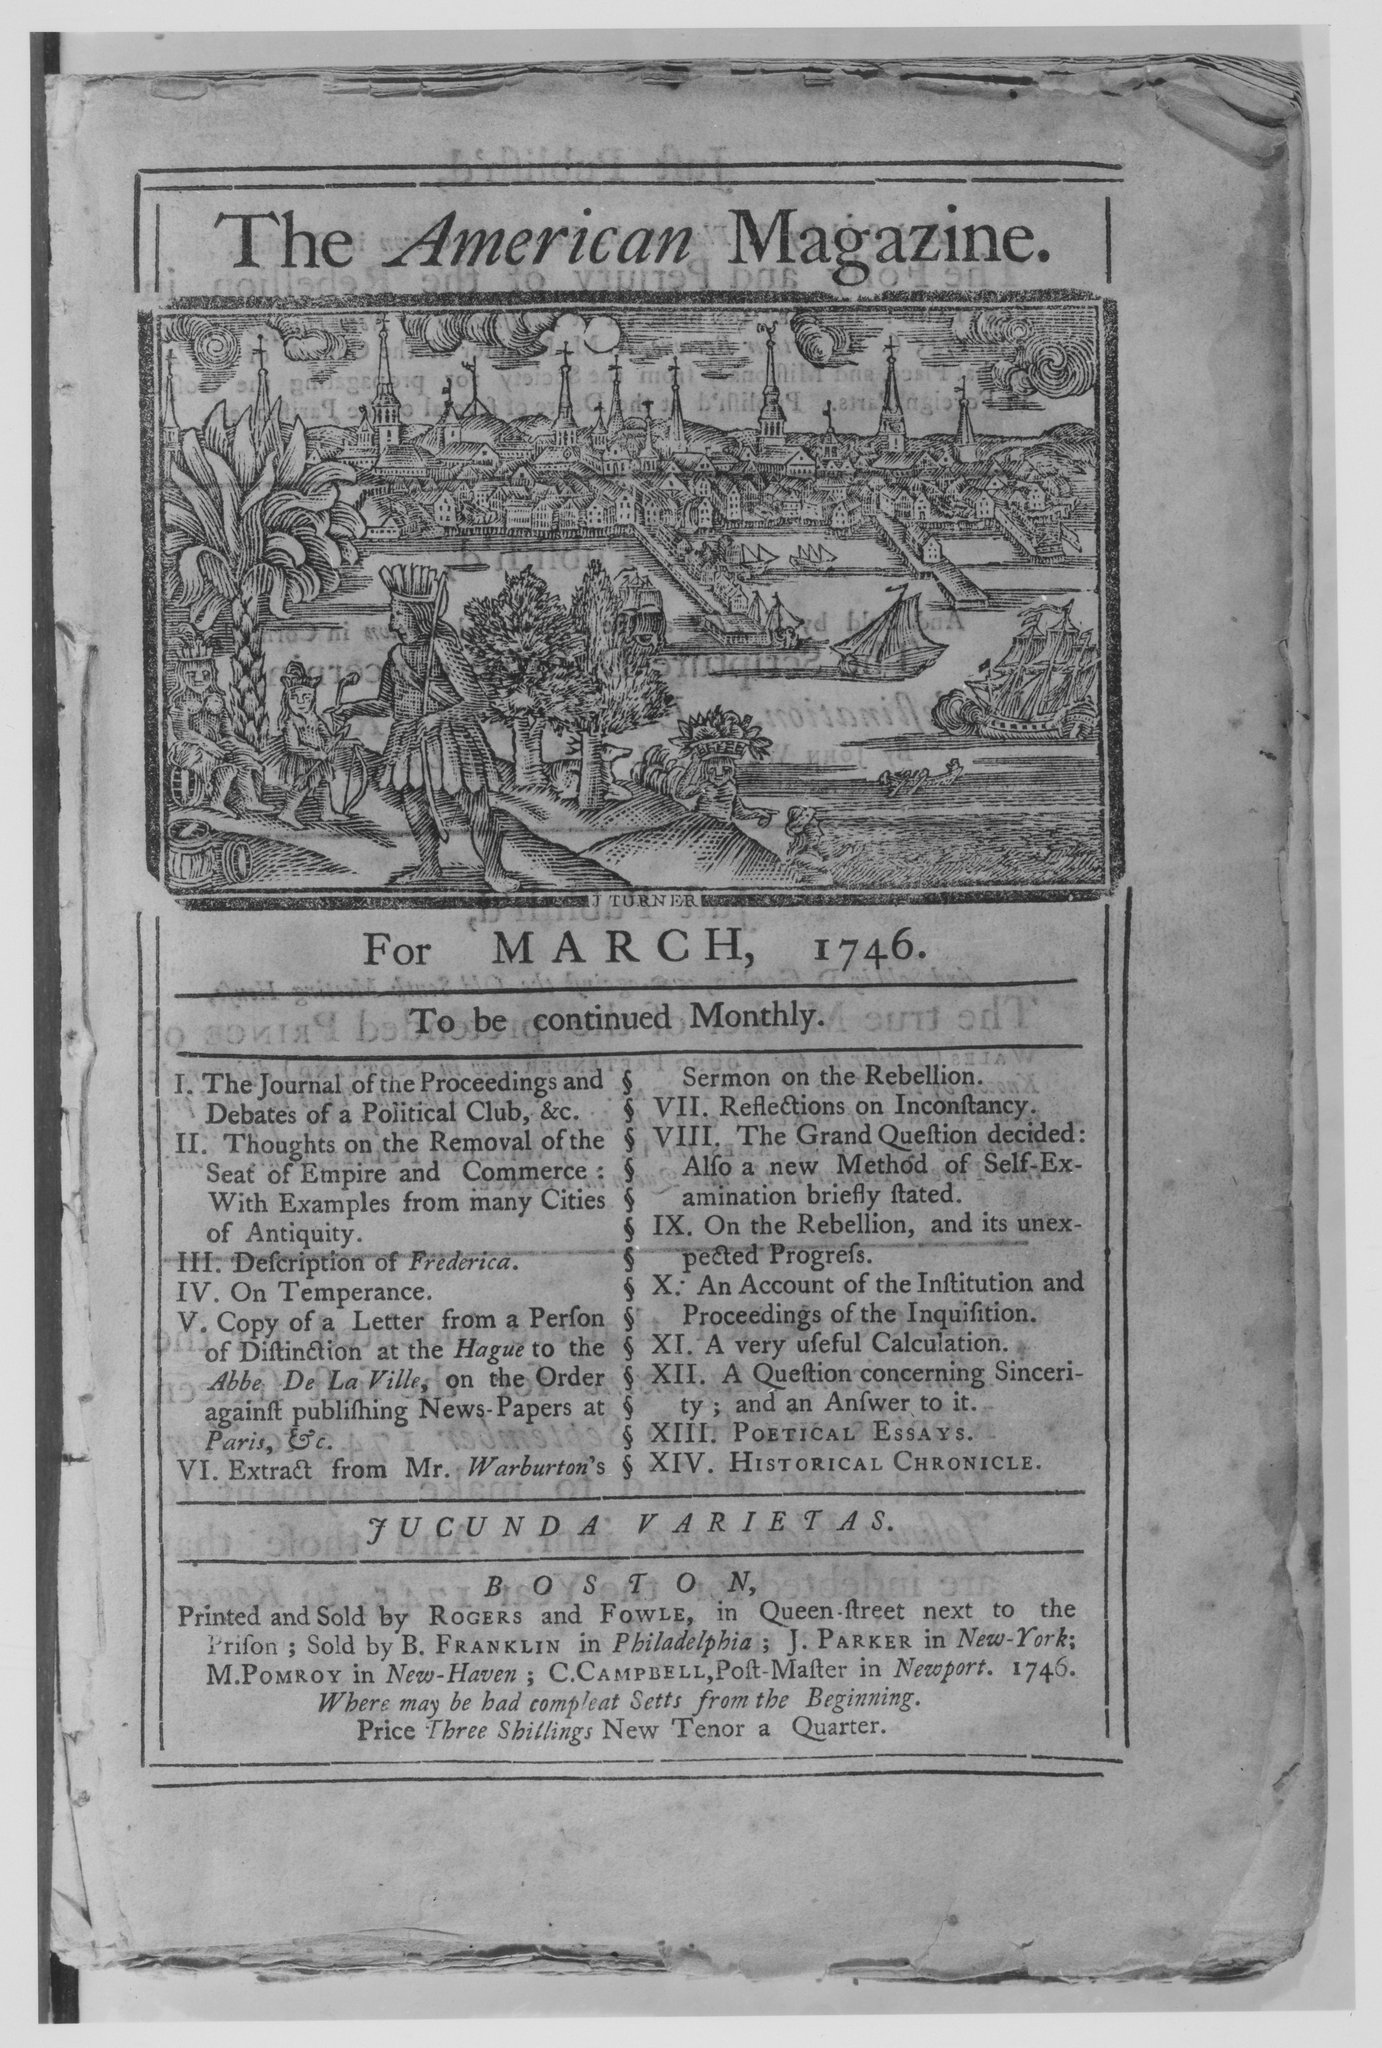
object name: book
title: The American Magazine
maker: rogers and fowle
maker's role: printer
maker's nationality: american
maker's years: 1700-1800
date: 1746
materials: metal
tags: cities